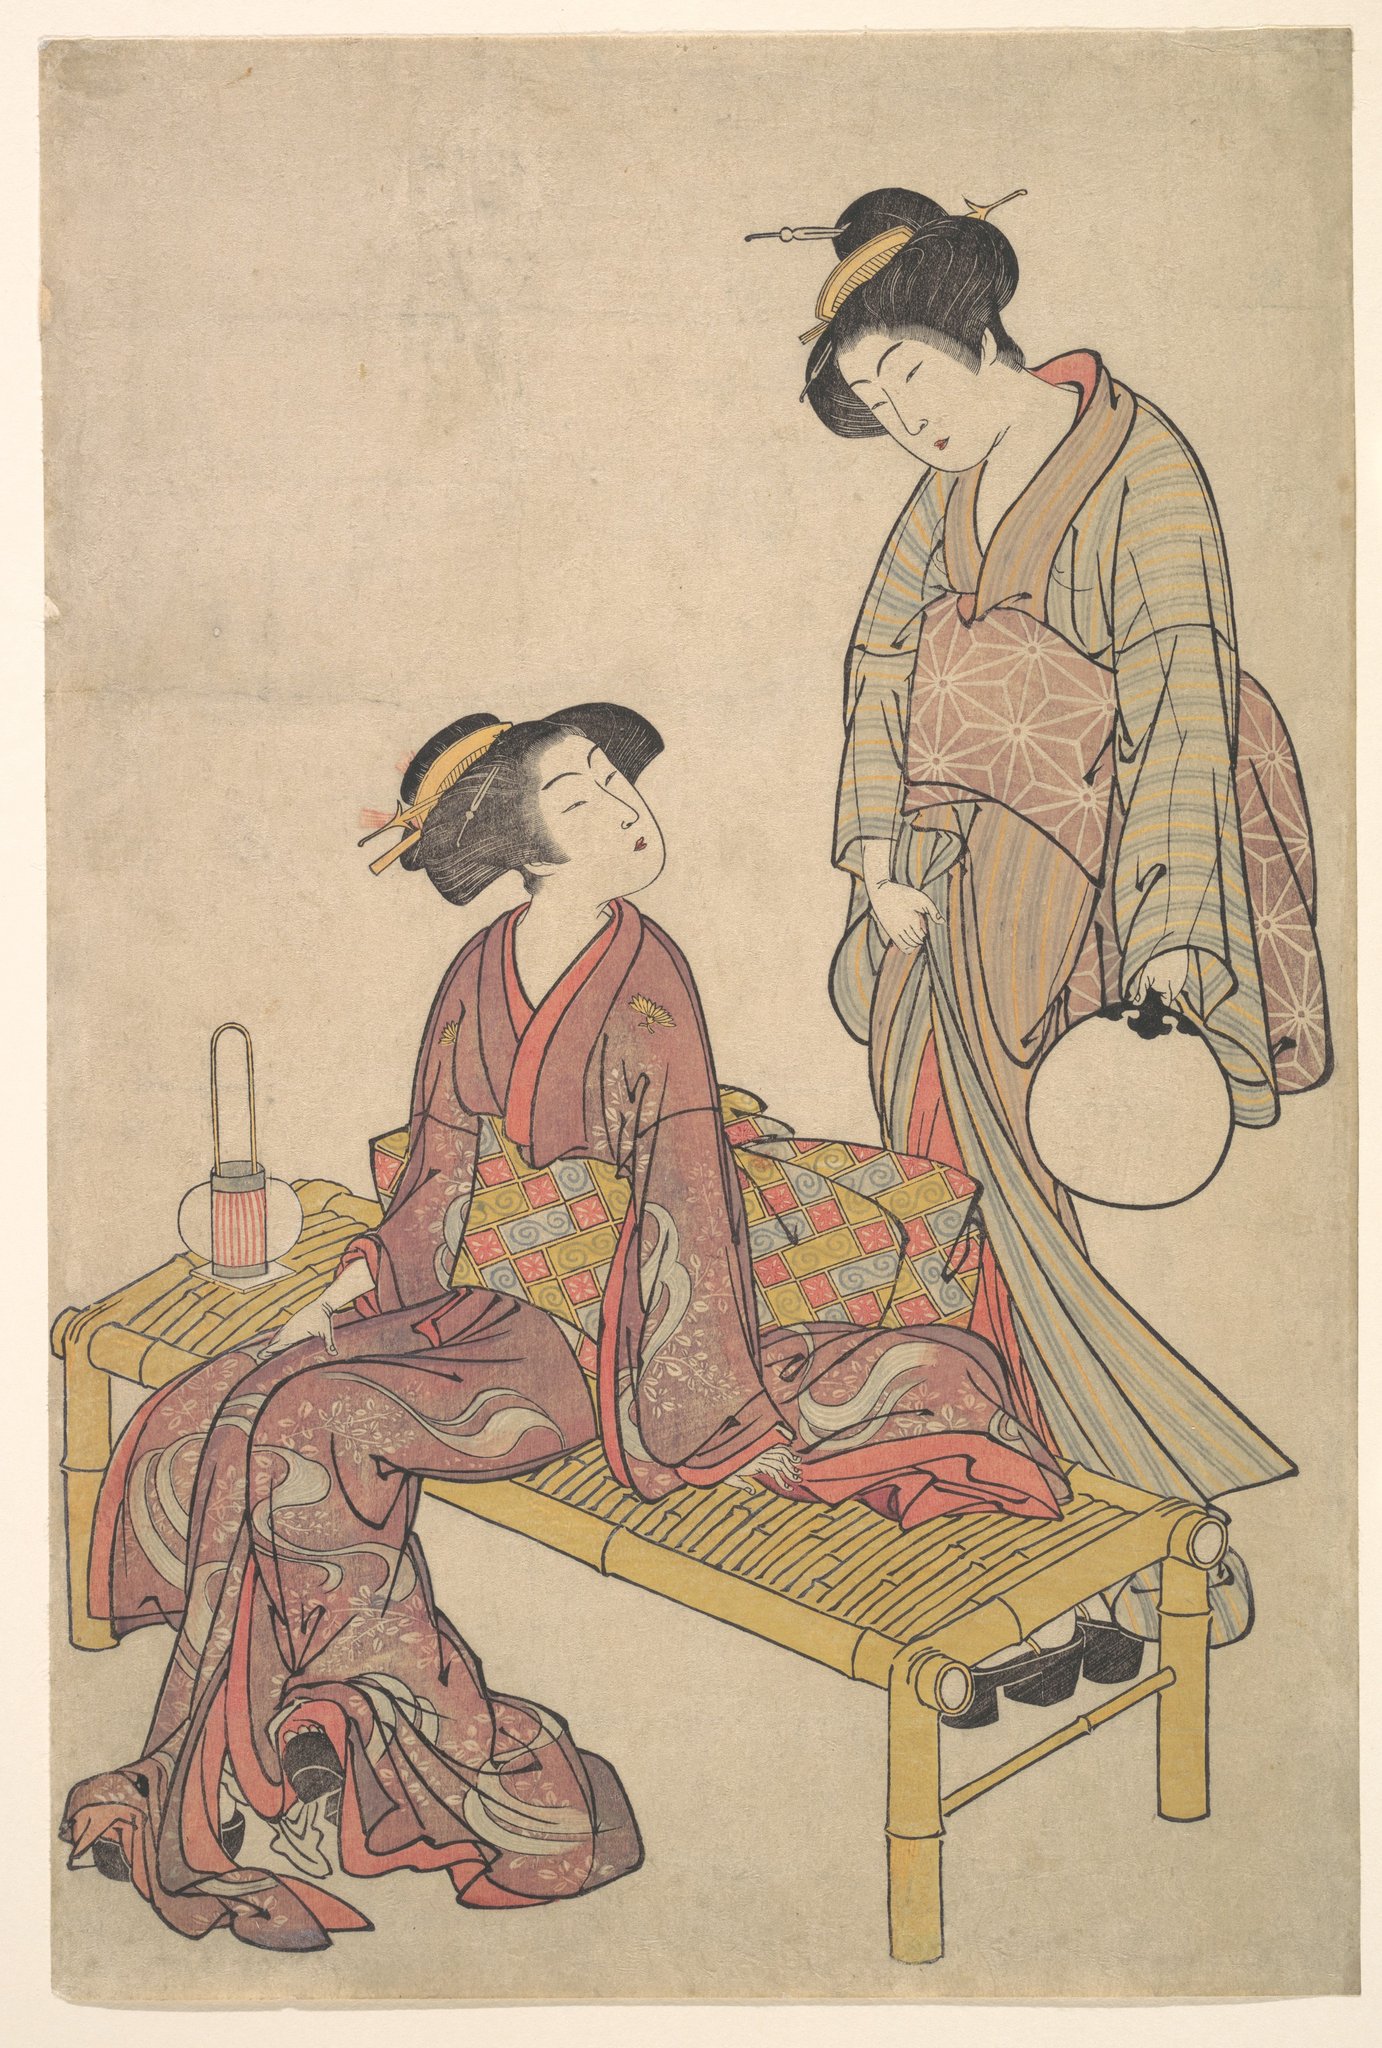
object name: woodblock print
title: The Hand Lantern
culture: japanese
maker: kitao shigemasa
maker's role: artist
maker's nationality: japanese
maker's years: 1739-1820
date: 1790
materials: ink, paper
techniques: woodblock print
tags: fans,women,lanterns